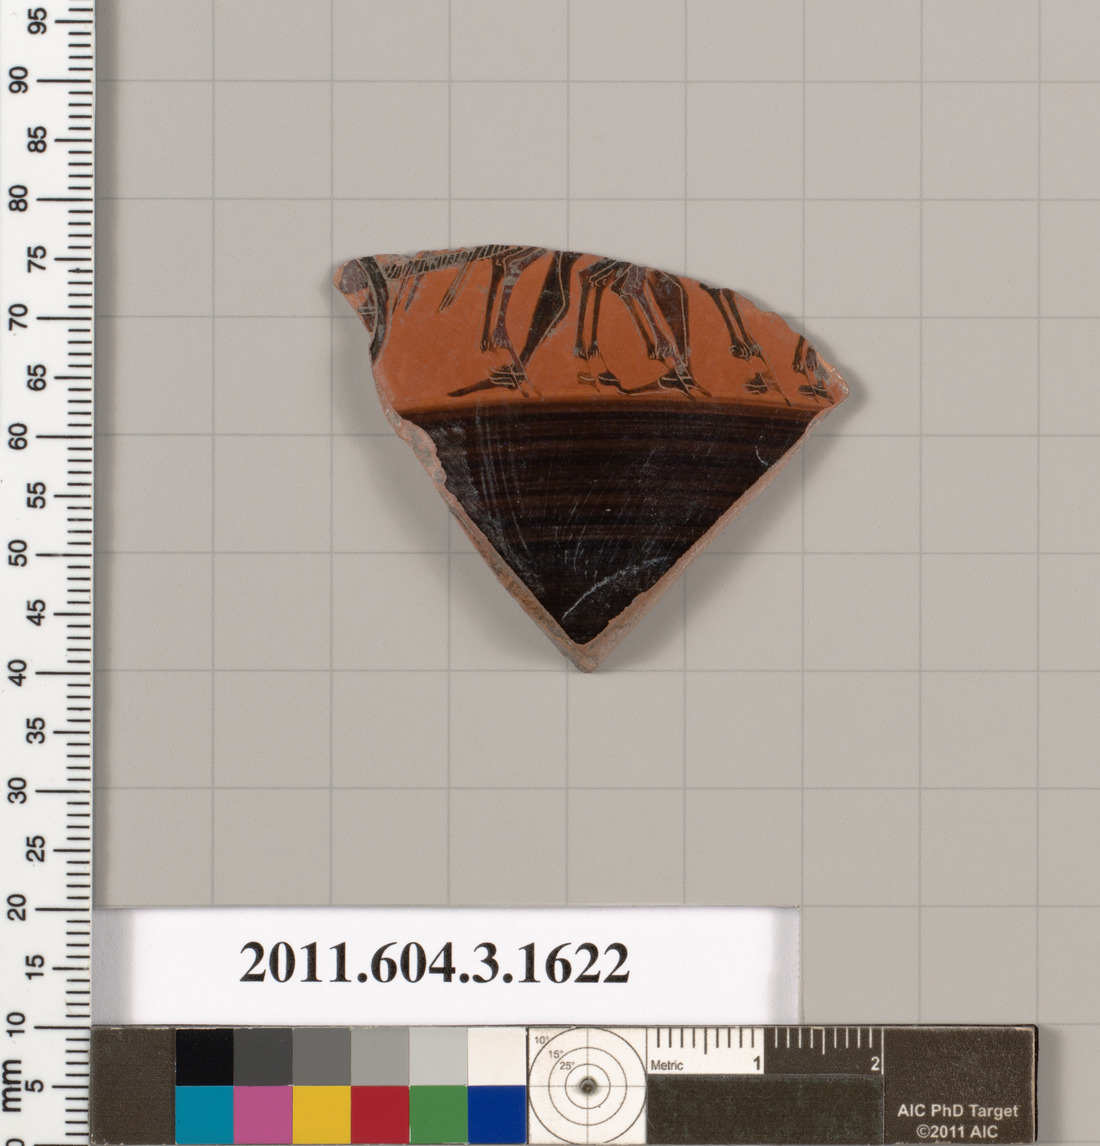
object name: kylix fragment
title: Terracotta fragment of a kylix: Band cup (drinking cup)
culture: greek, attic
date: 567-535 BCE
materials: terracotta